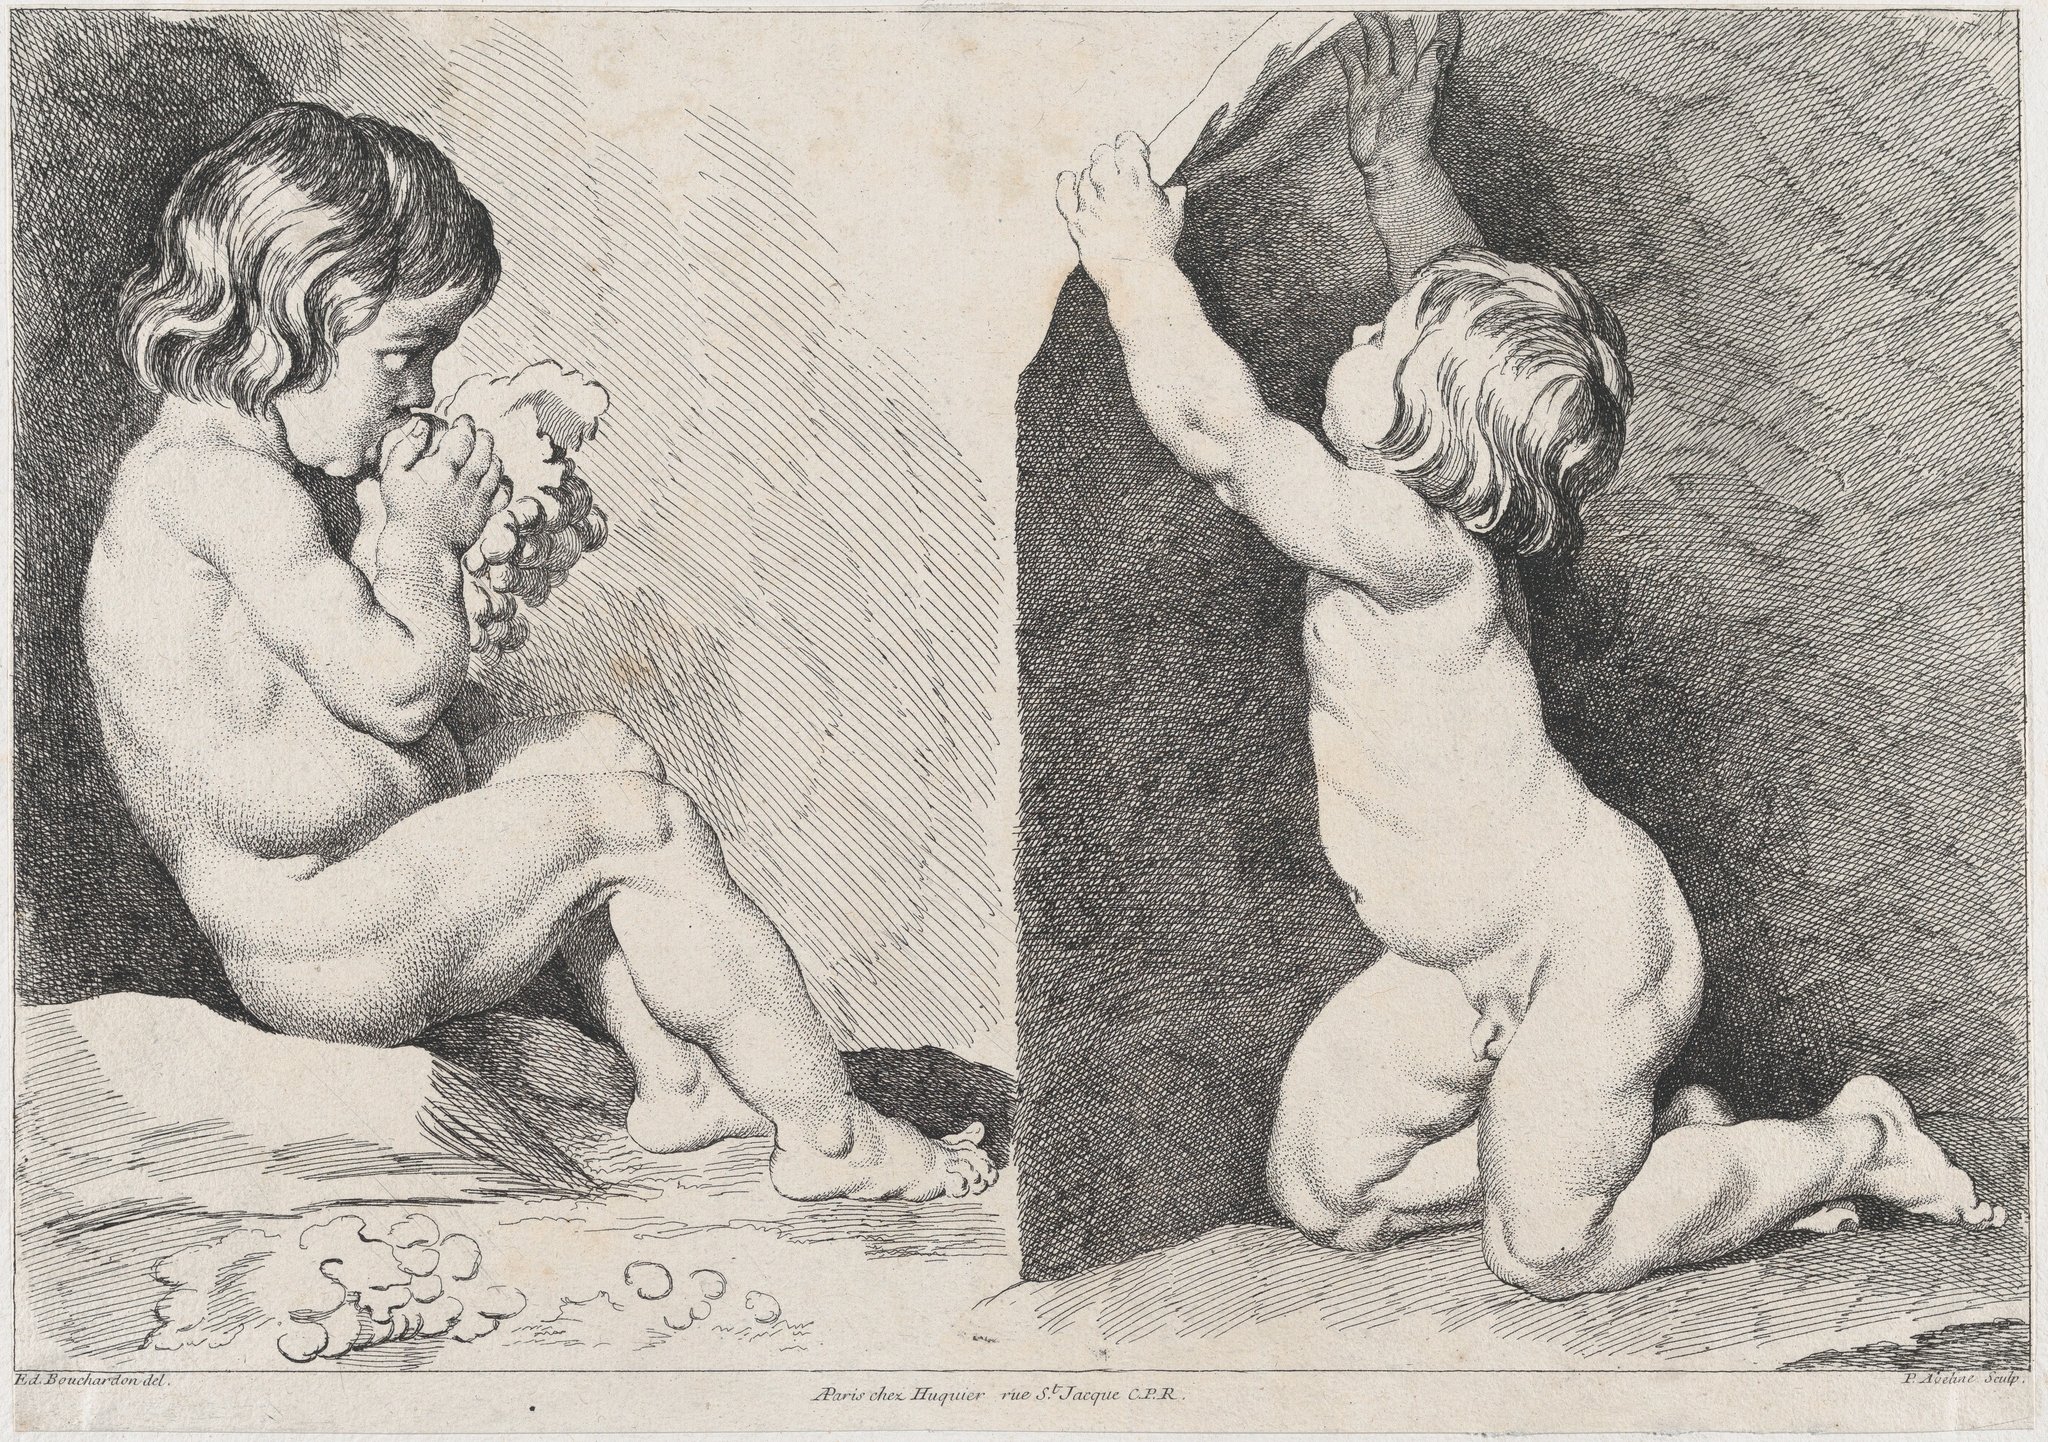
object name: print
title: Two nude children eating grapes, from "New Book of Children"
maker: pierre alexandre aveline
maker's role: artist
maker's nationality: french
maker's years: 1702-1760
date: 1720-1760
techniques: etching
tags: grapes,children